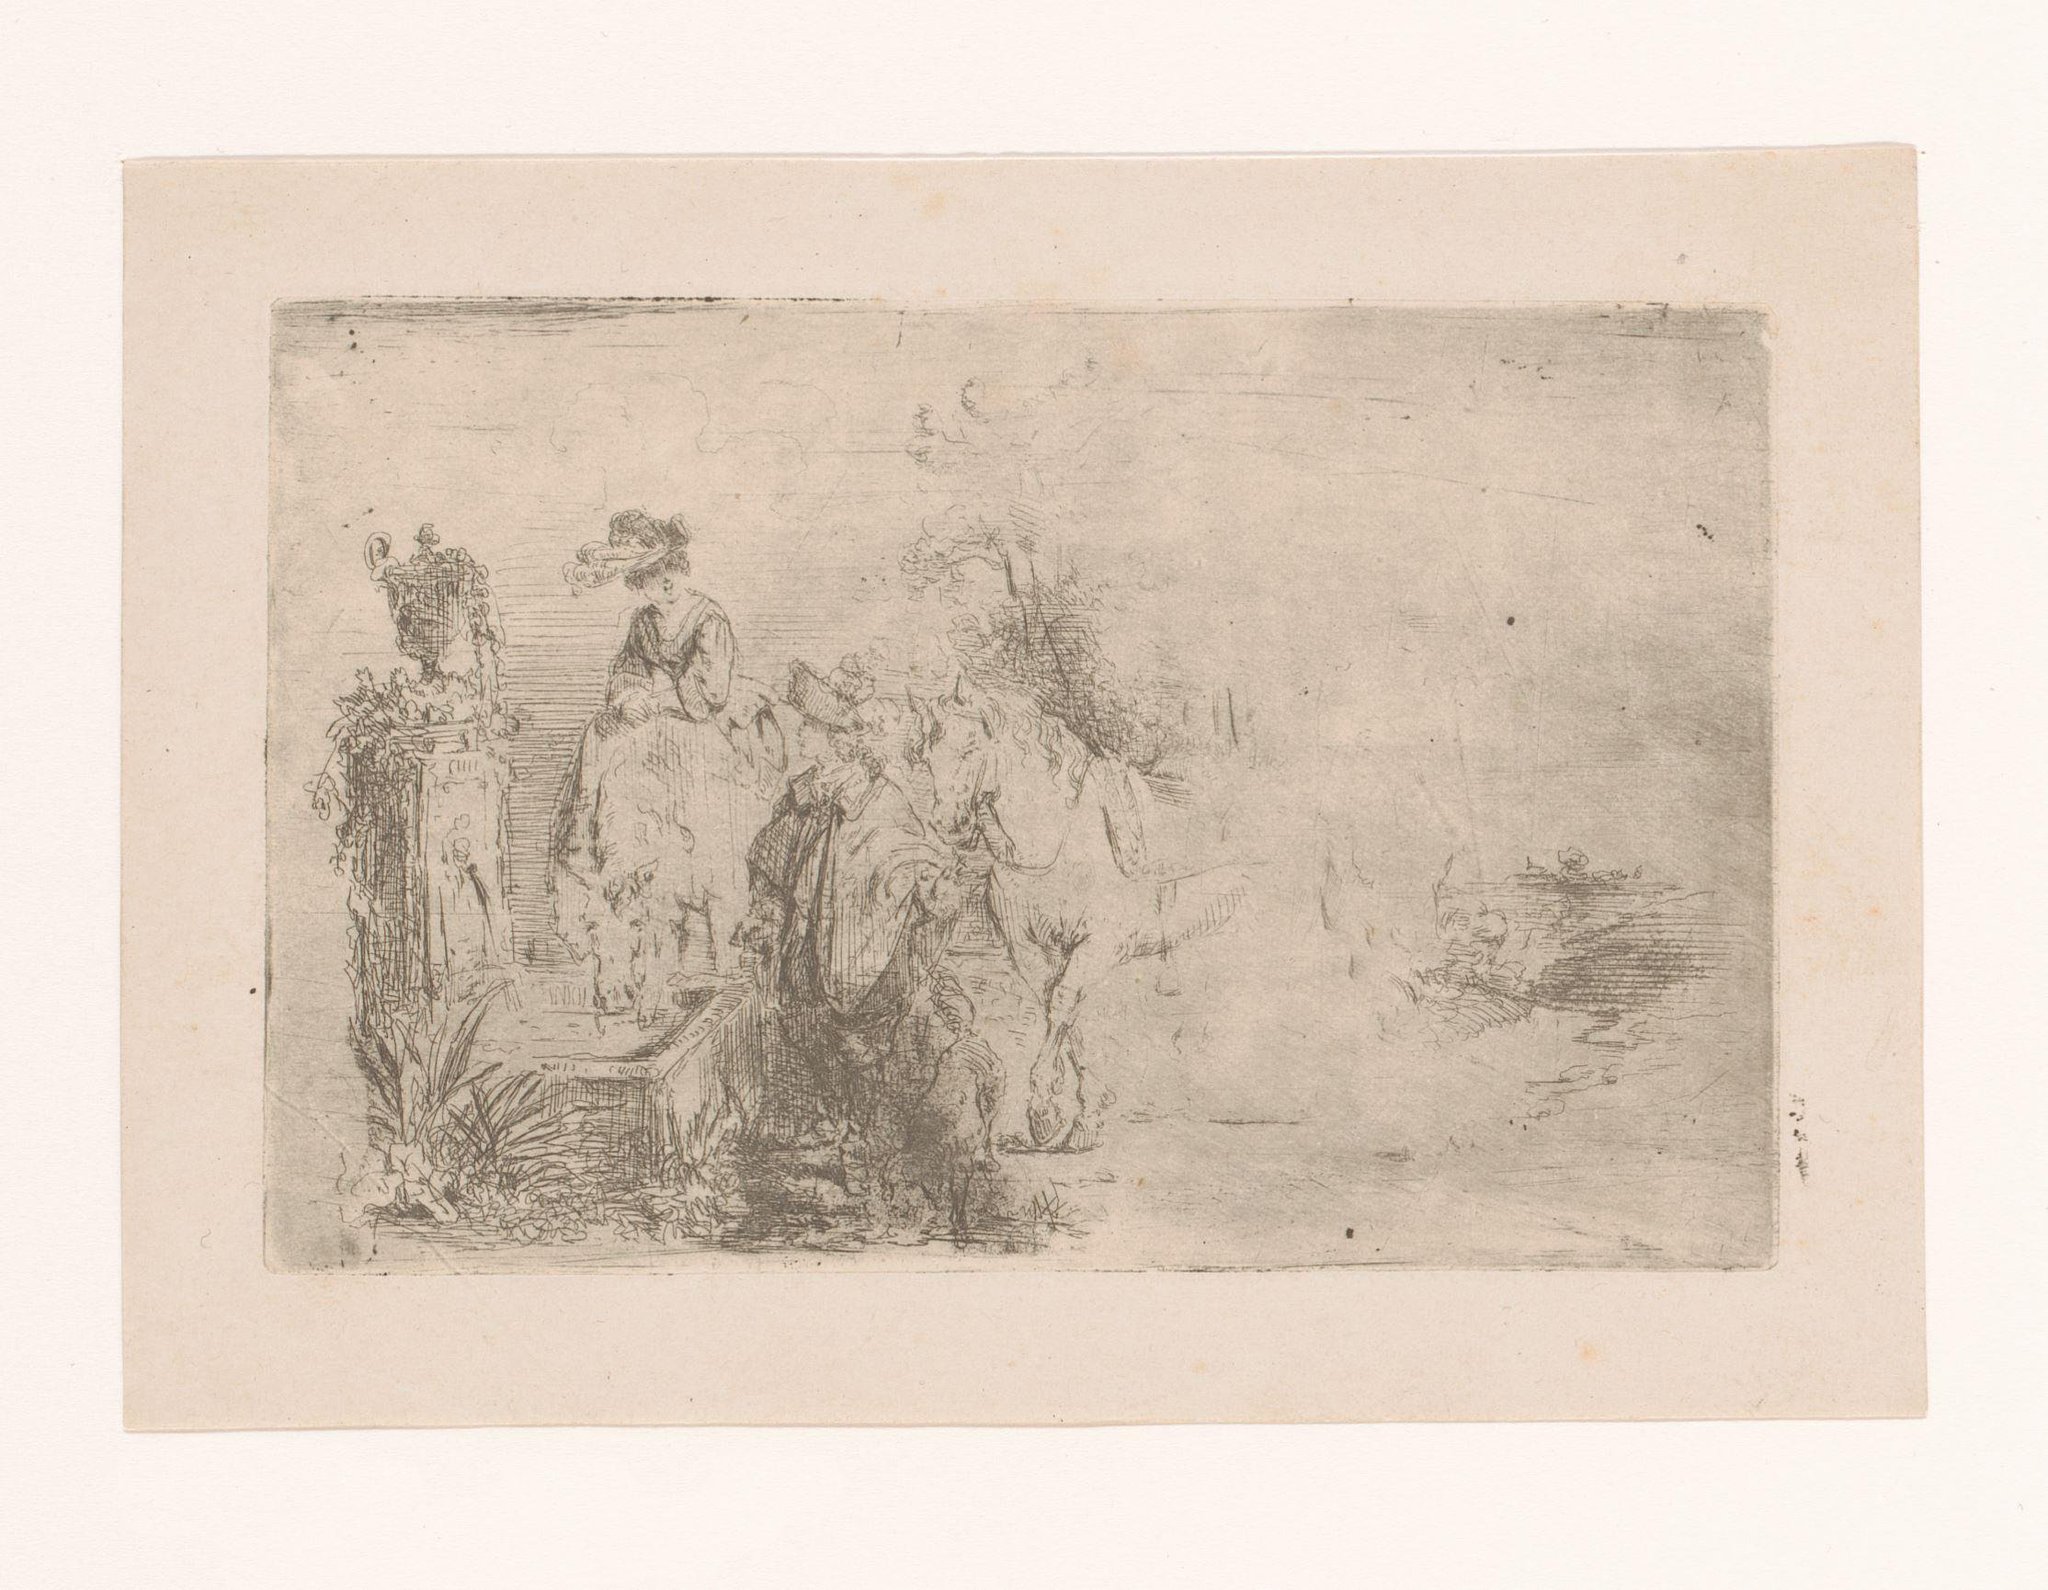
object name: print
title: Gesprek bij een drinkbak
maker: adrien joseph verhoeven-ball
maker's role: draughtsman, print maker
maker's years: 1824-1882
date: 1834-1882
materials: paper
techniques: drypoint, etching, intaglio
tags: horse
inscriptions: collector's mark: Lugt 2228, collector's mark: Lugt 1485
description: Man en vrouw in gesprek, terwijl ze hun paarden laten drinken bij een drinkbak.